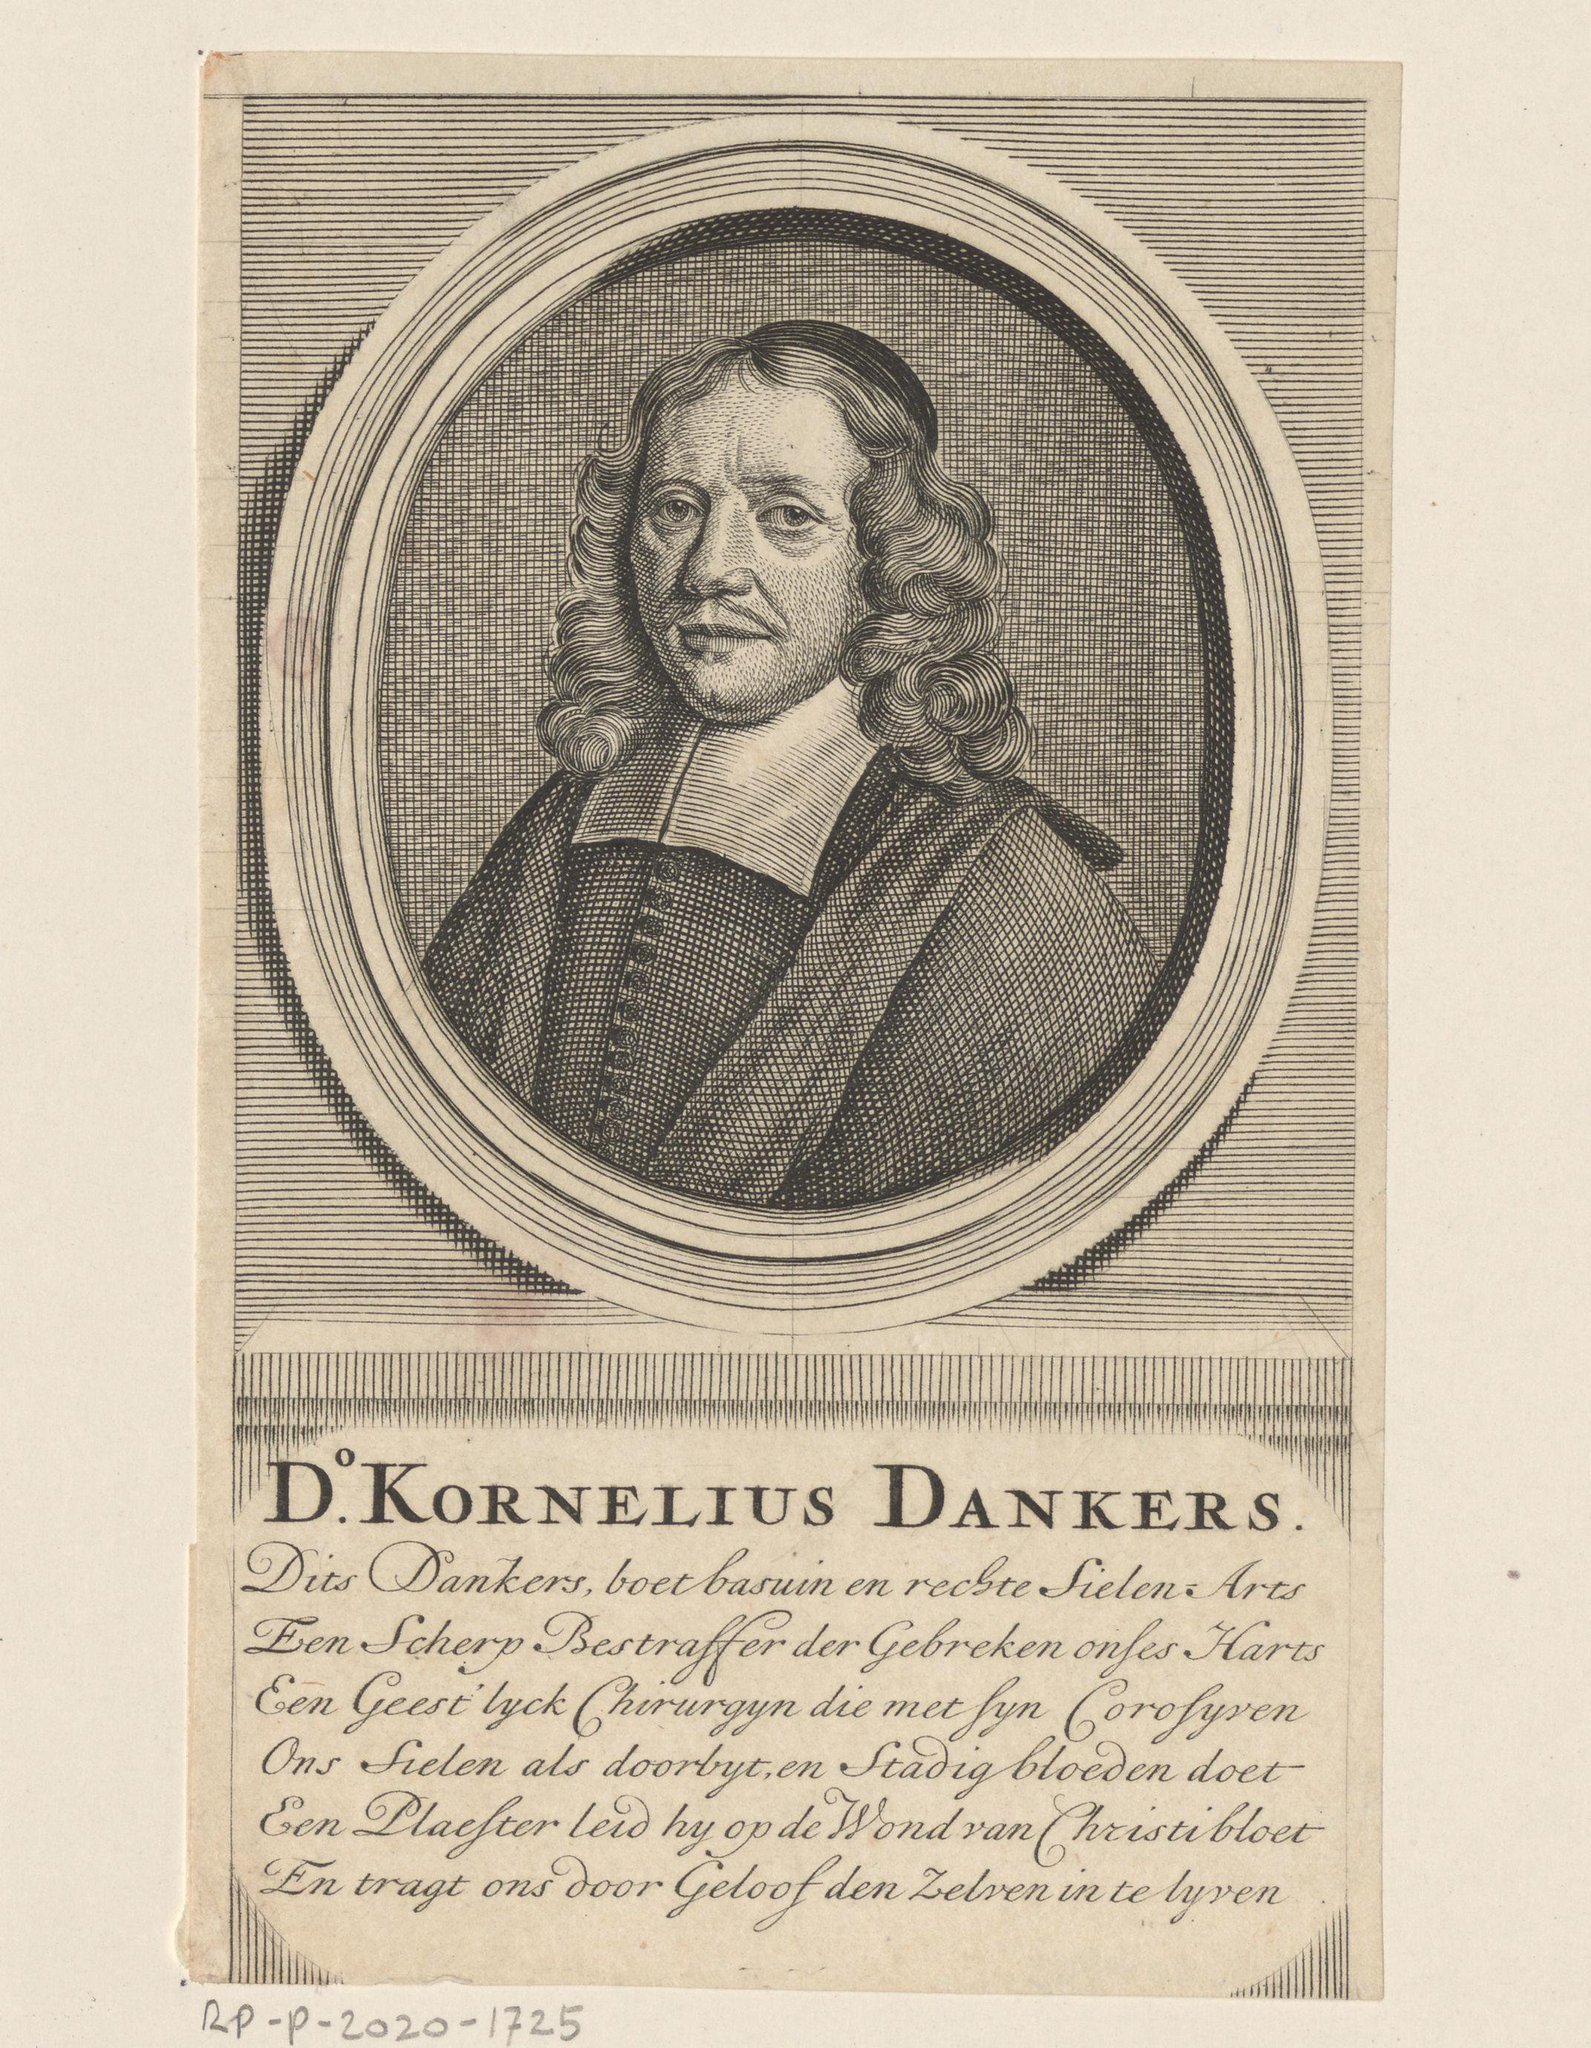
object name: print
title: Portret van Cornelis Danckerts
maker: Anonymous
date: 1686-1749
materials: paper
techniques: engraving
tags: historical persons, organization, functionaries and dignitaries in churches and in related institutions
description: De eerste staat van deze prent maakt deel uit van een grotere prent met twaalf portretten van Amsterdamse predikanten, uitgegeven door P. van Opoeteren in 1686 in Amsterdam.